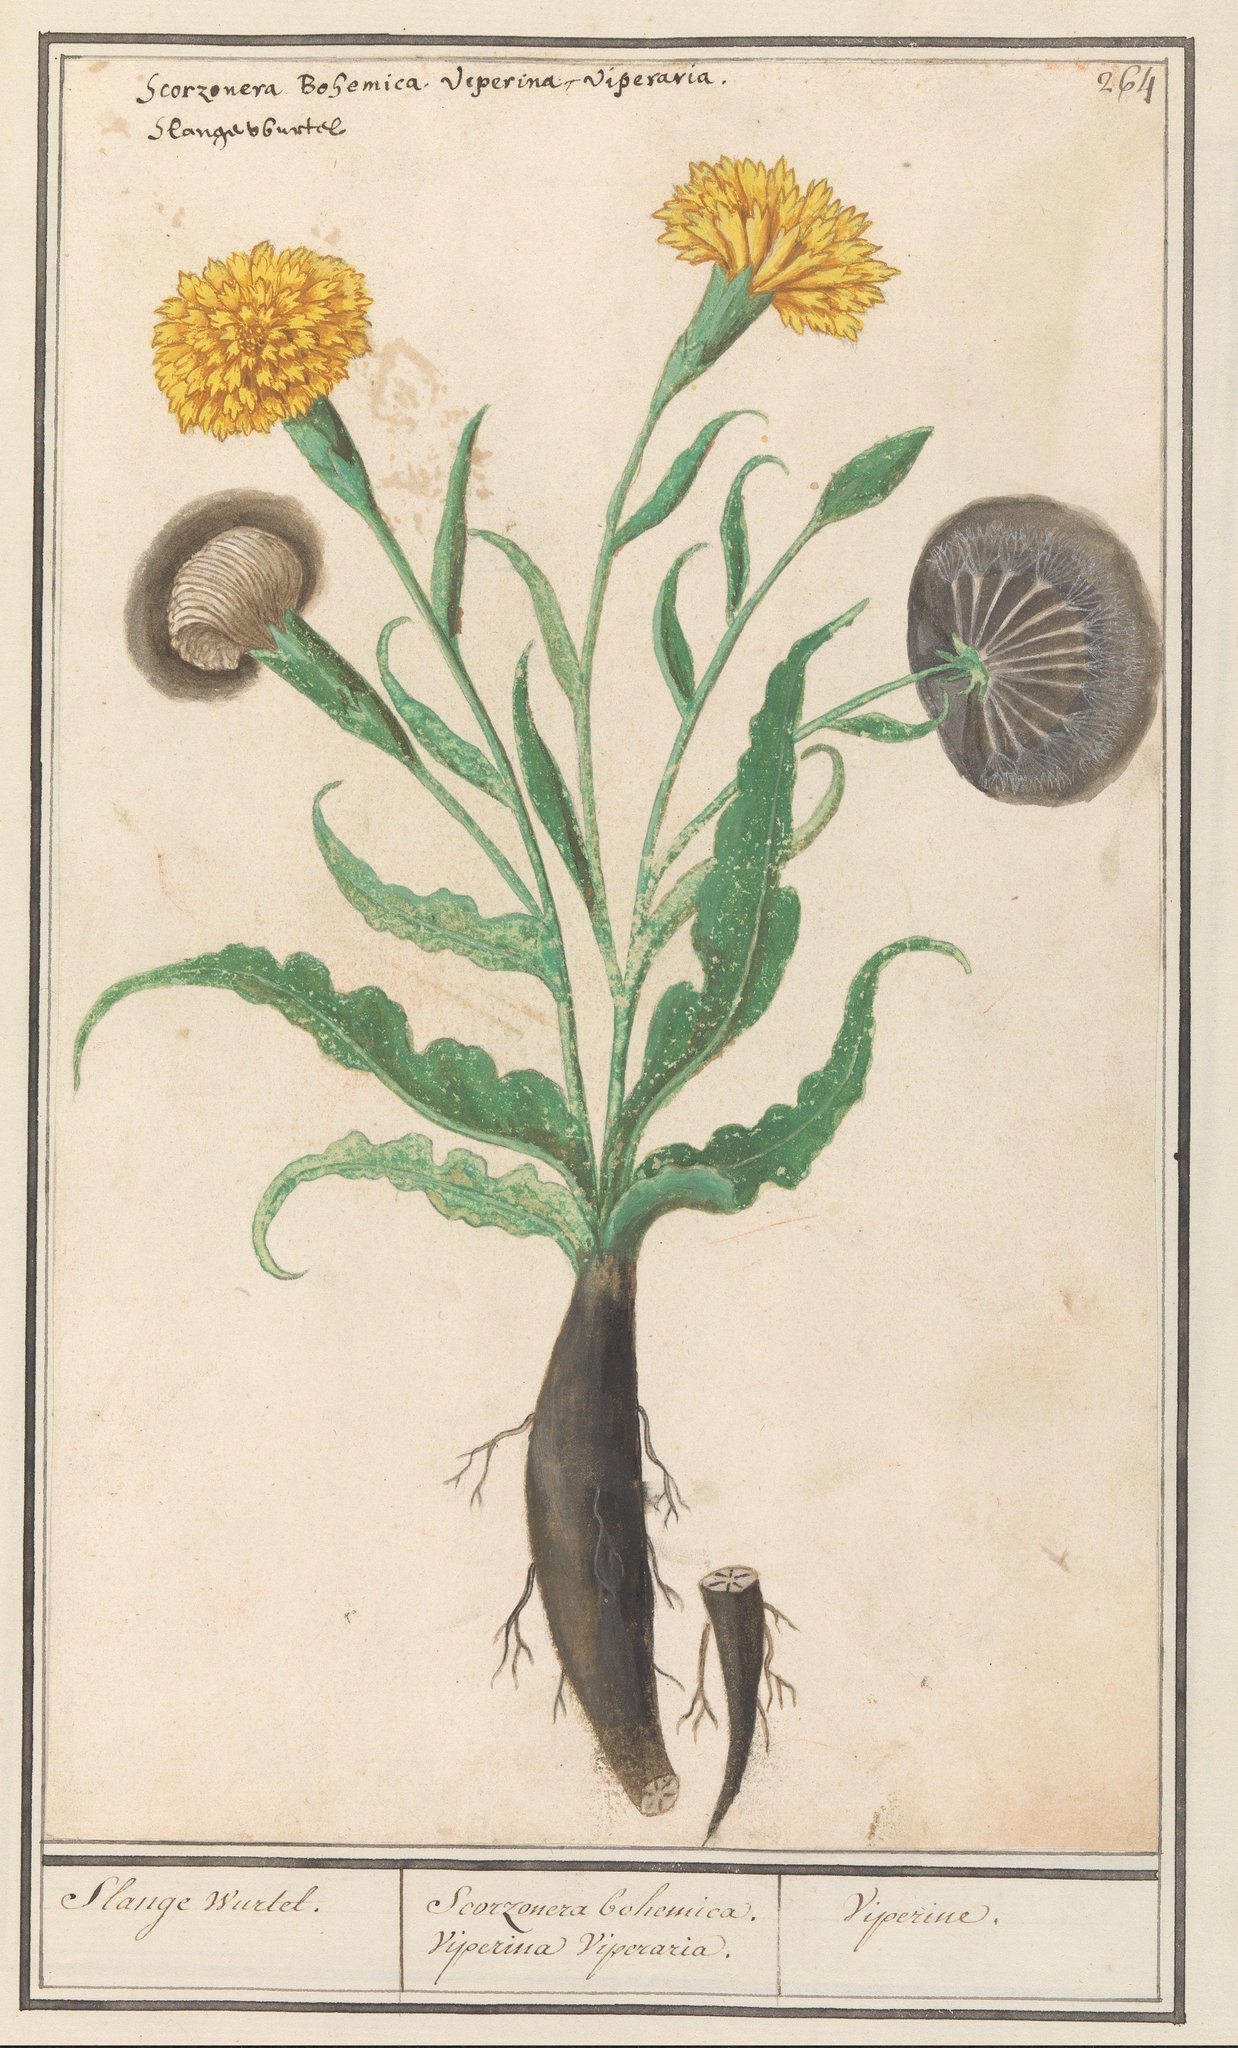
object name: drawing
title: Kleine schorseneer (Scorzonera humilis)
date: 1596-1610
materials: chalk, paint, ink, paper, watercolor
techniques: brush, pen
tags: flowers: scorzonera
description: Kleine schorseneer. Genummerd rechtsboven: 264. Linksbovenaan de Latijnse en Nederlandse naam. Onderdeel van het derde album met tekeningen van bloemen en planten. Tiende van twaalf albums met tekeningen van dieren, vogels en planten bekend rond 1600, gemaakt in opdracht van keizer Rudolf II. Met toelichting in Nederlands, Latijn en Frans.